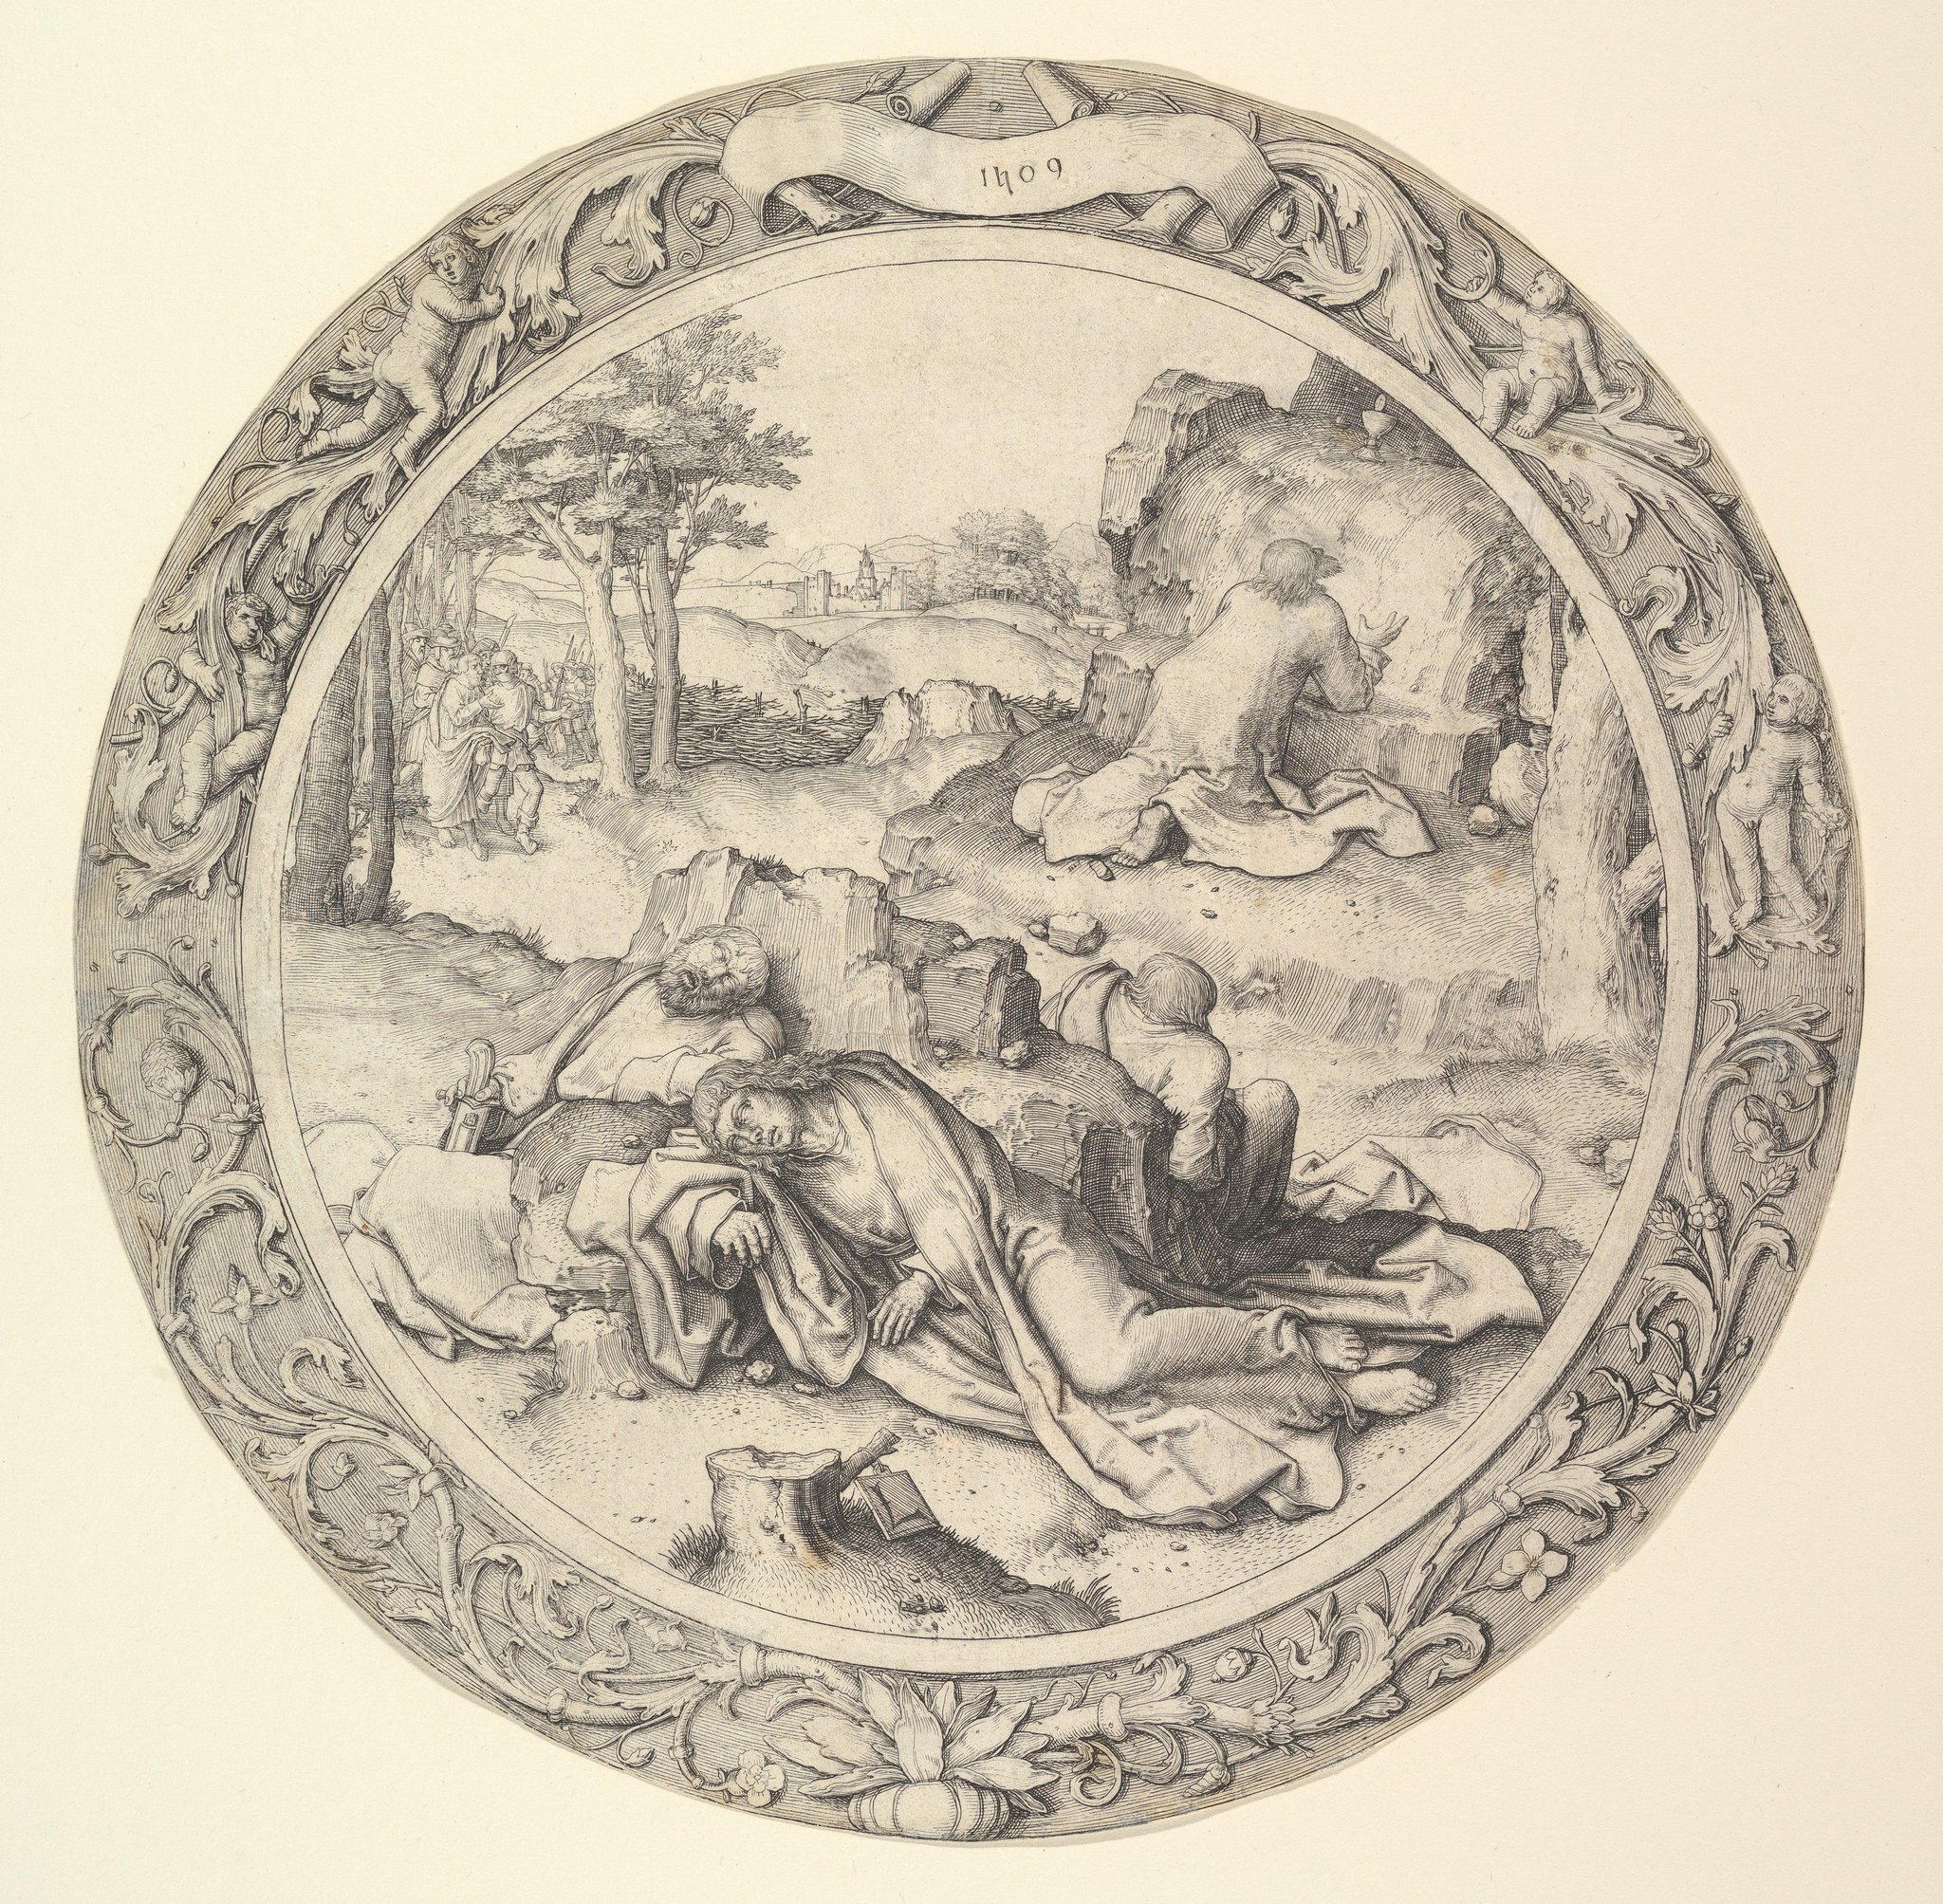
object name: print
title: Christ on the Mount of Olives, from the Circular Passion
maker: lucas van leyden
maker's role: artist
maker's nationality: netherlandish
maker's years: 1494-1533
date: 1509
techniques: engraving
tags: men,women,trees,christ